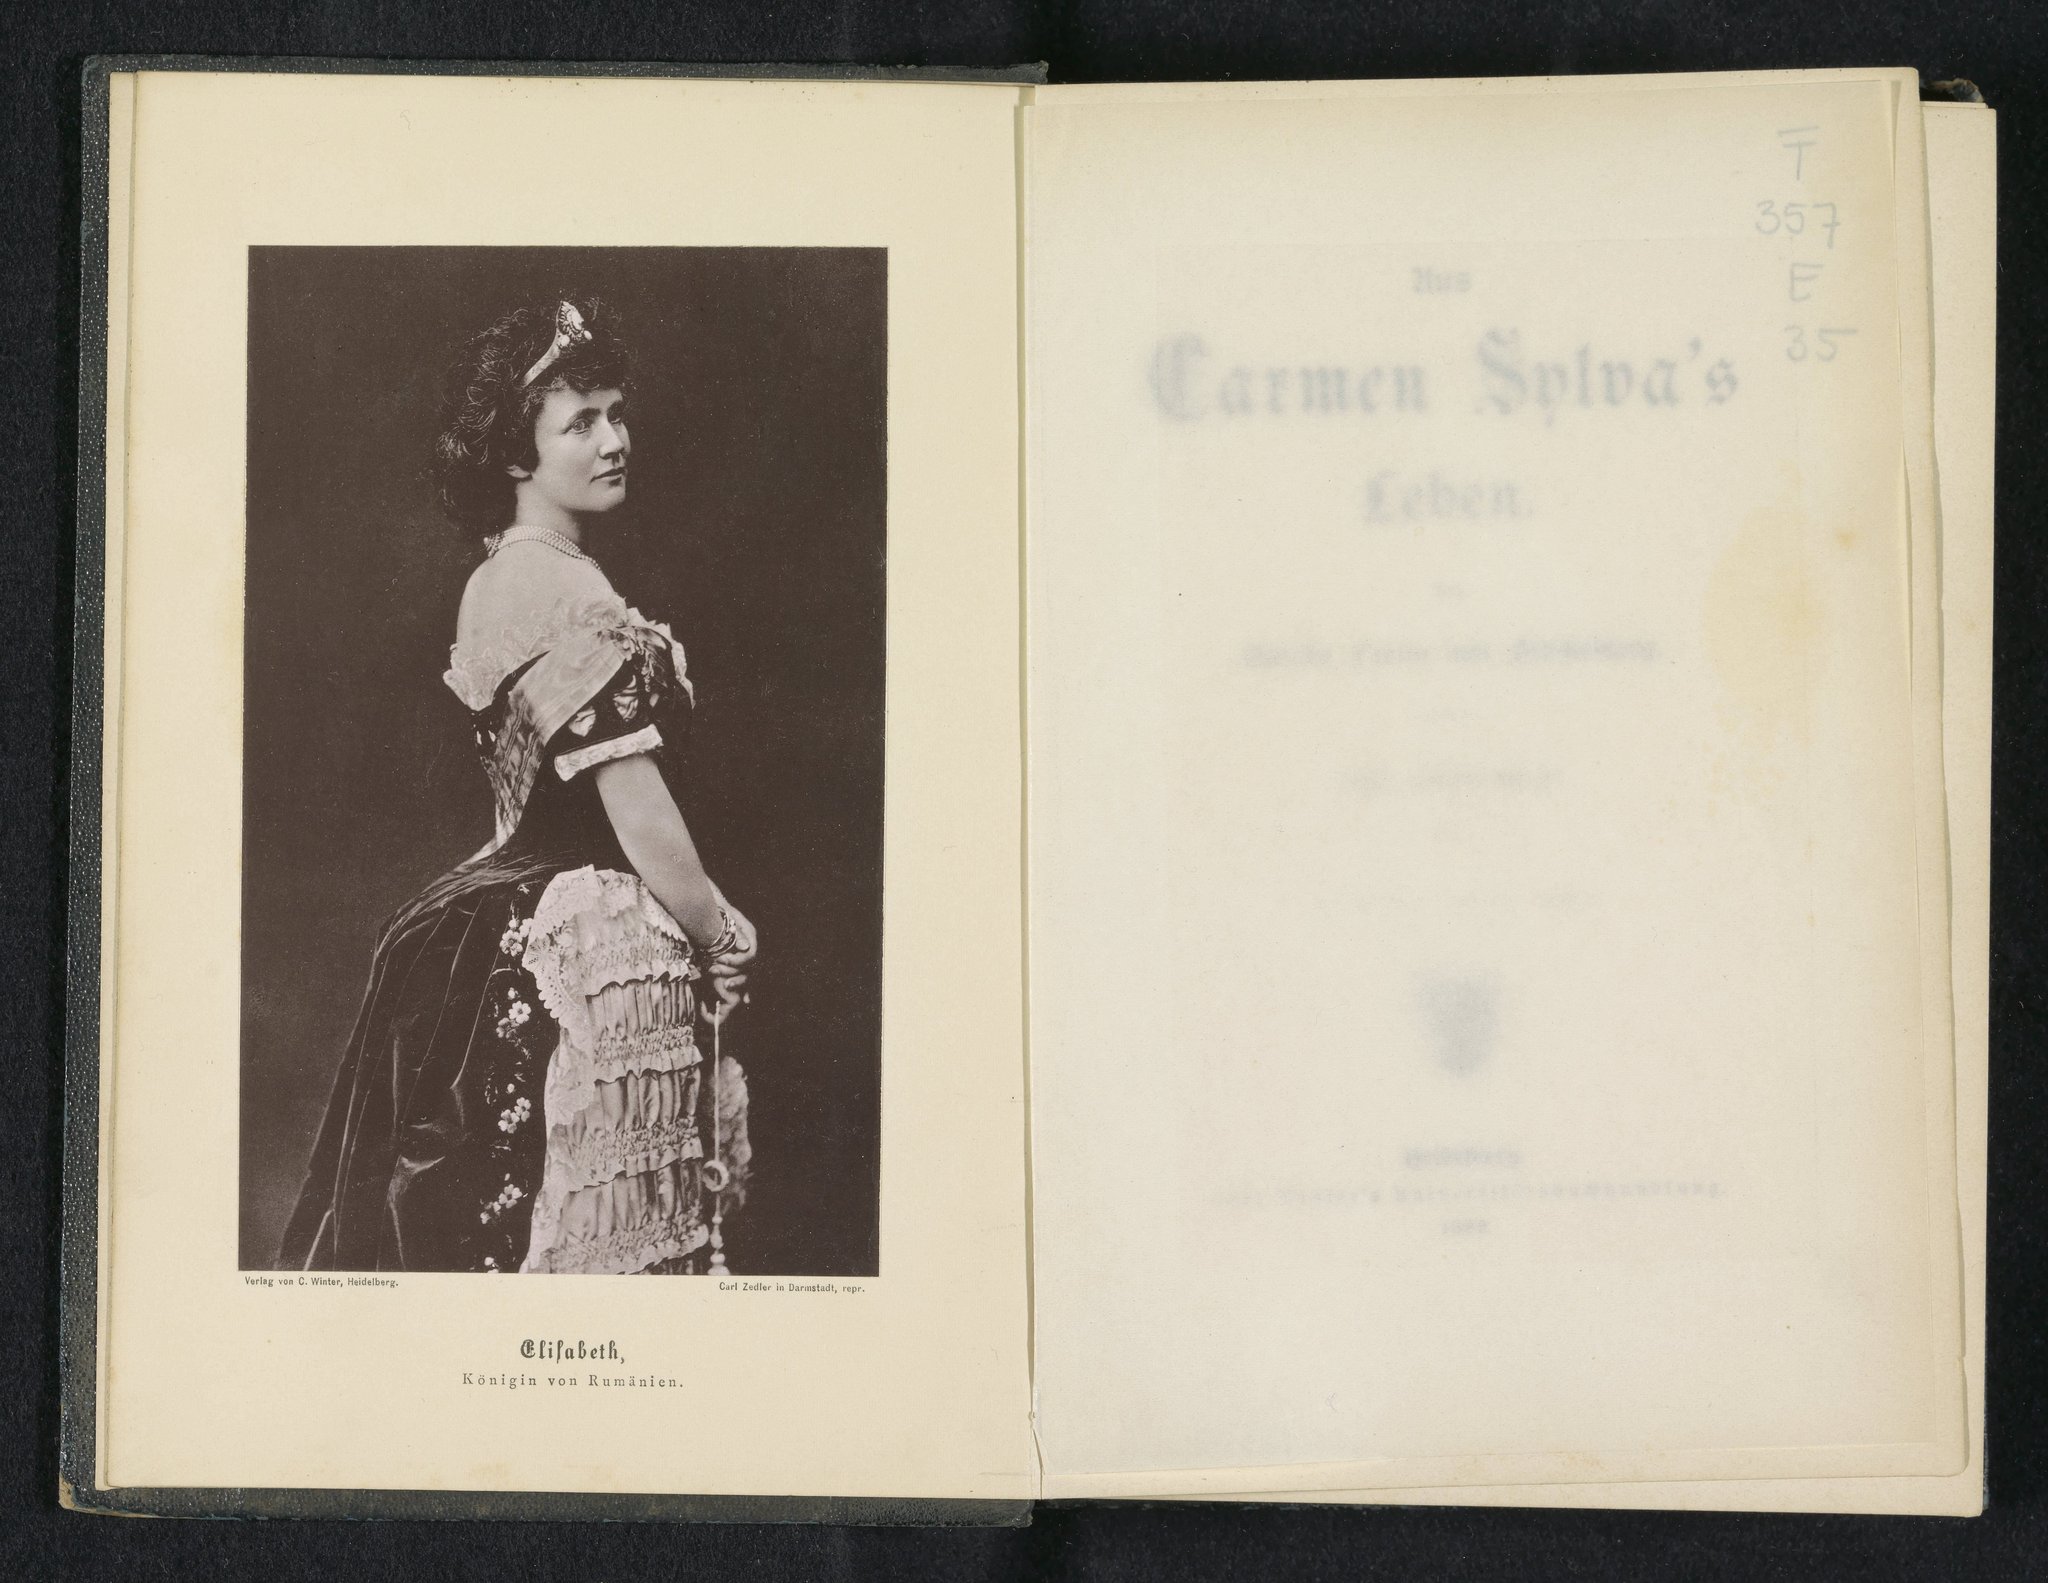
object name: page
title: Elisabeth, Königin von Rumänien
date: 1879-1889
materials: paper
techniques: photograph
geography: heidelberg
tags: queen